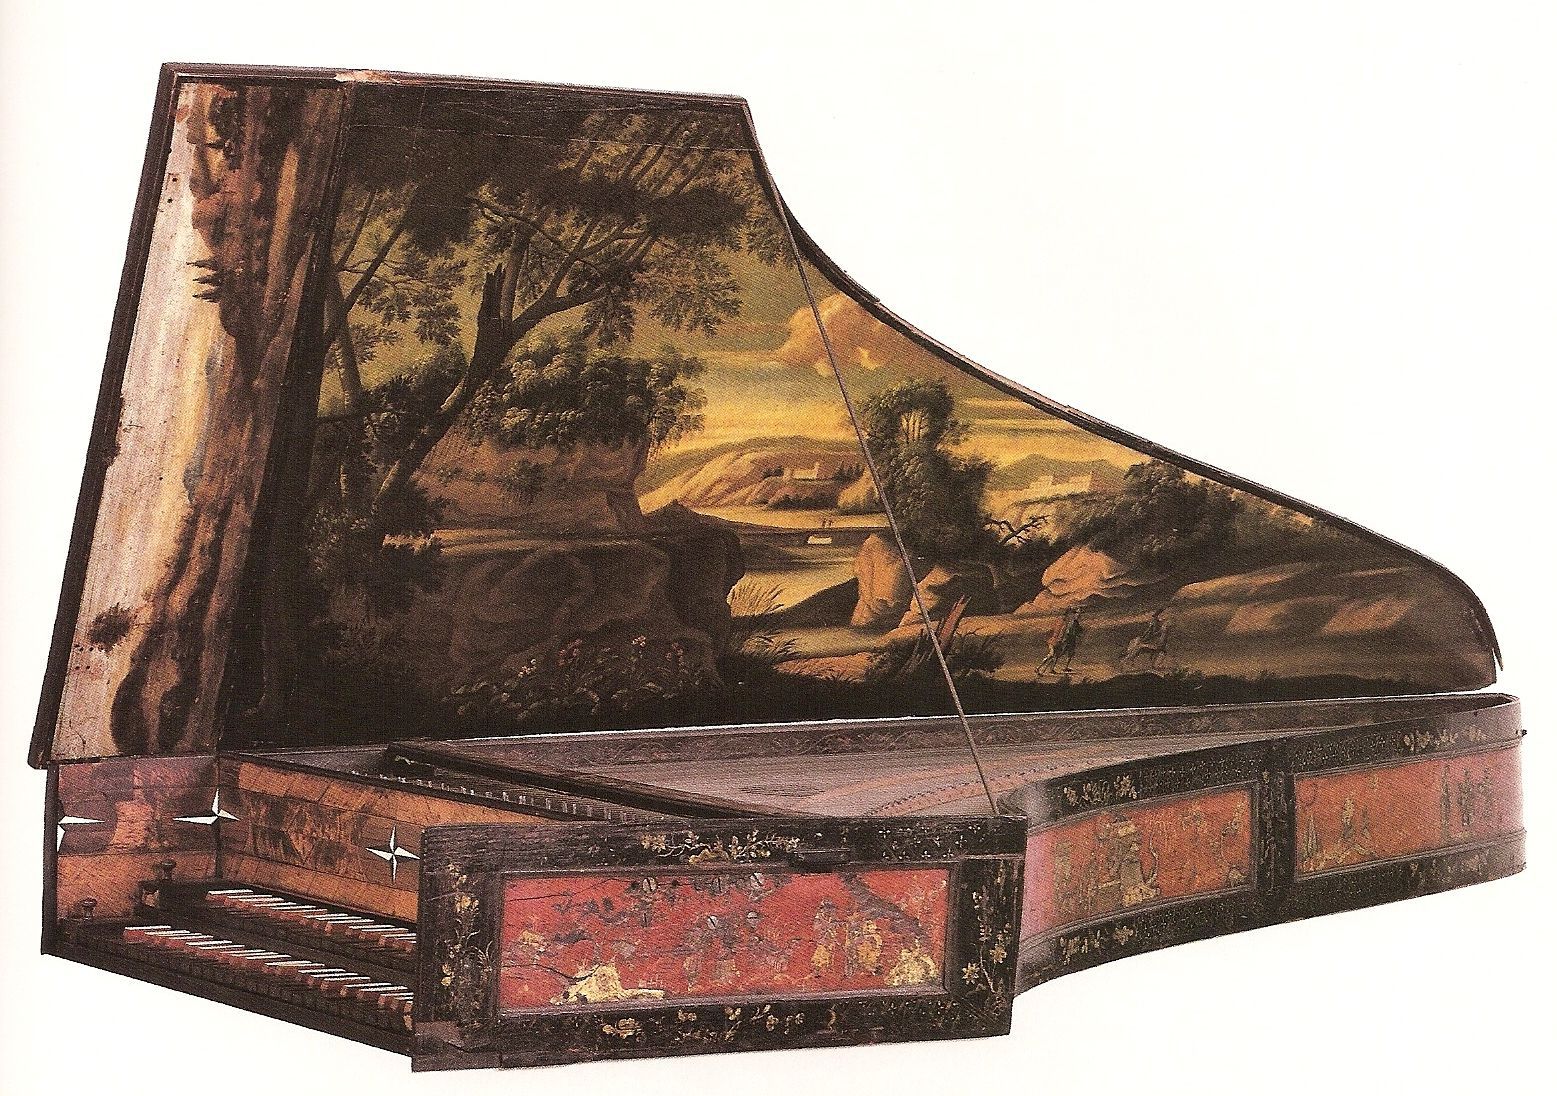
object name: claviorganum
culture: german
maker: herman willenbrock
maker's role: maker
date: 1712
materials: wood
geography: germany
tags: landscapes